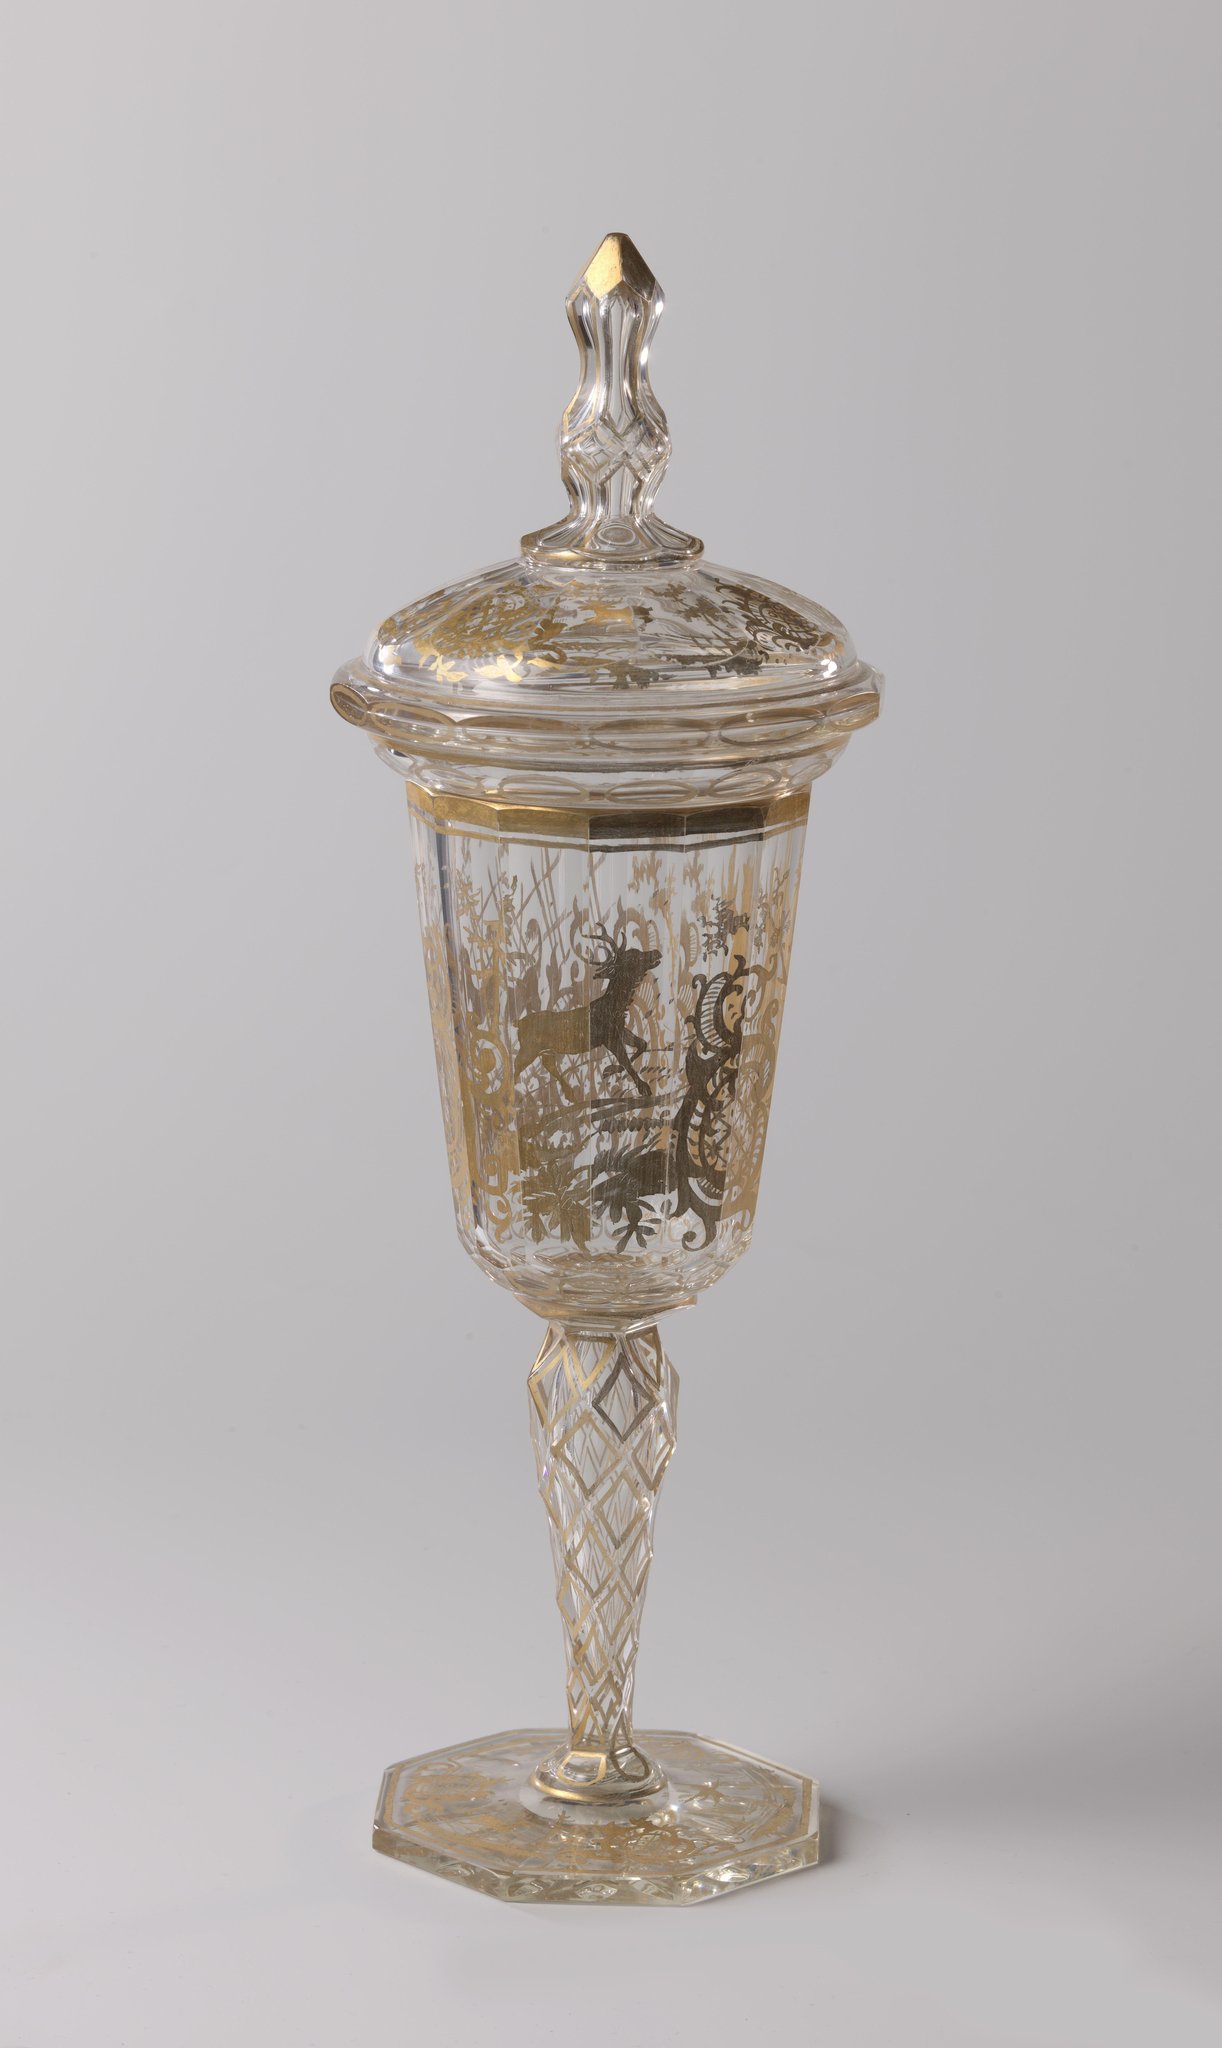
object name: lid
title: Deksel van bokaal met deksel, met een jachtscène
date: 1850-1875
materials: glass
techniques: gilding, glassblowing, grinding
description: Gewelfde, facetgeslepen deksel met overkragende rand en een facetgeslepen, balustervormige knop, eindigend in een punt. Op het deksel een hert, een ooievaar en een hond omgeven door rocailleornament.